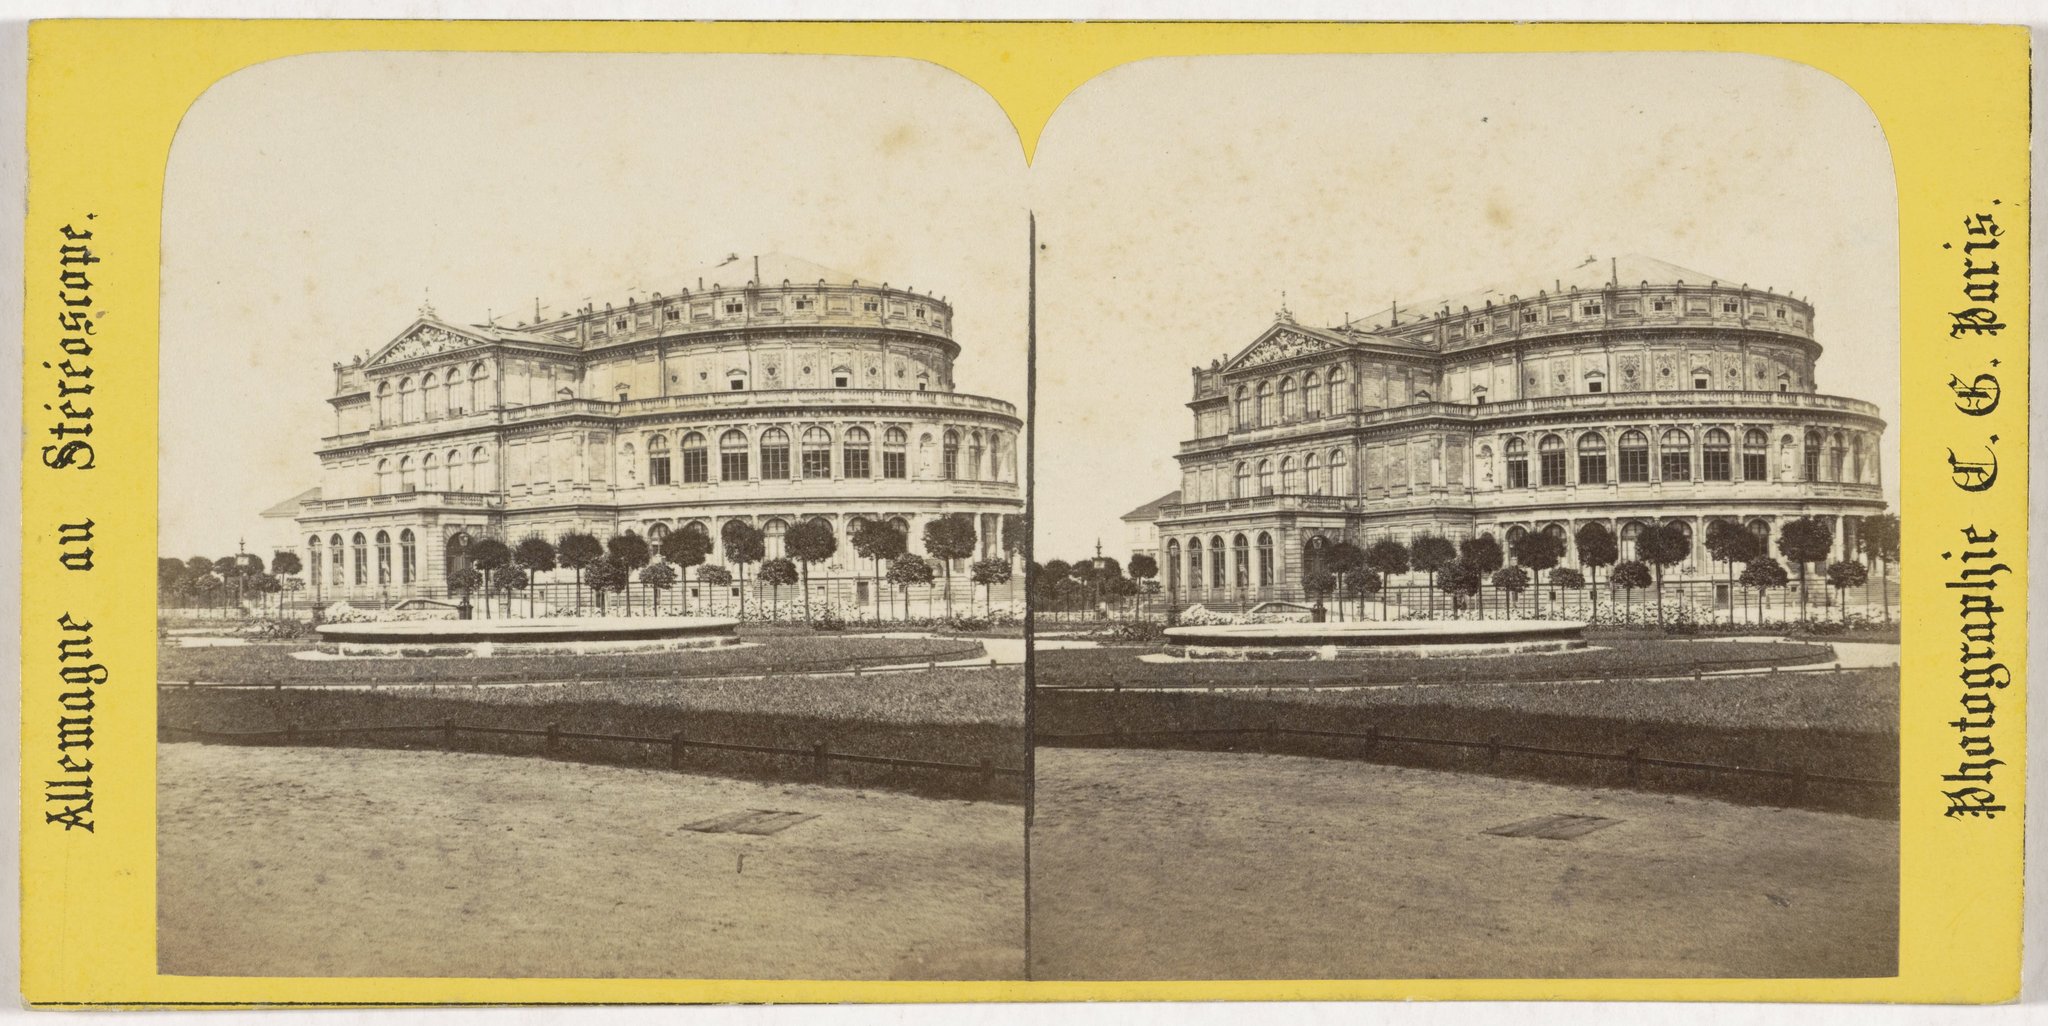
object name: stereograph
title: Dresde (Saxe), vue générale du théâtre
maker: charles gaudin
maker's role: publisher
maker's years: 1825-1905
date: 1860-1870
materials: cardboard, paper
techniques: albumen print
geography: dresden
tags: theatre (building)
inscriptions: number: ‘233’, number: ‘233.’